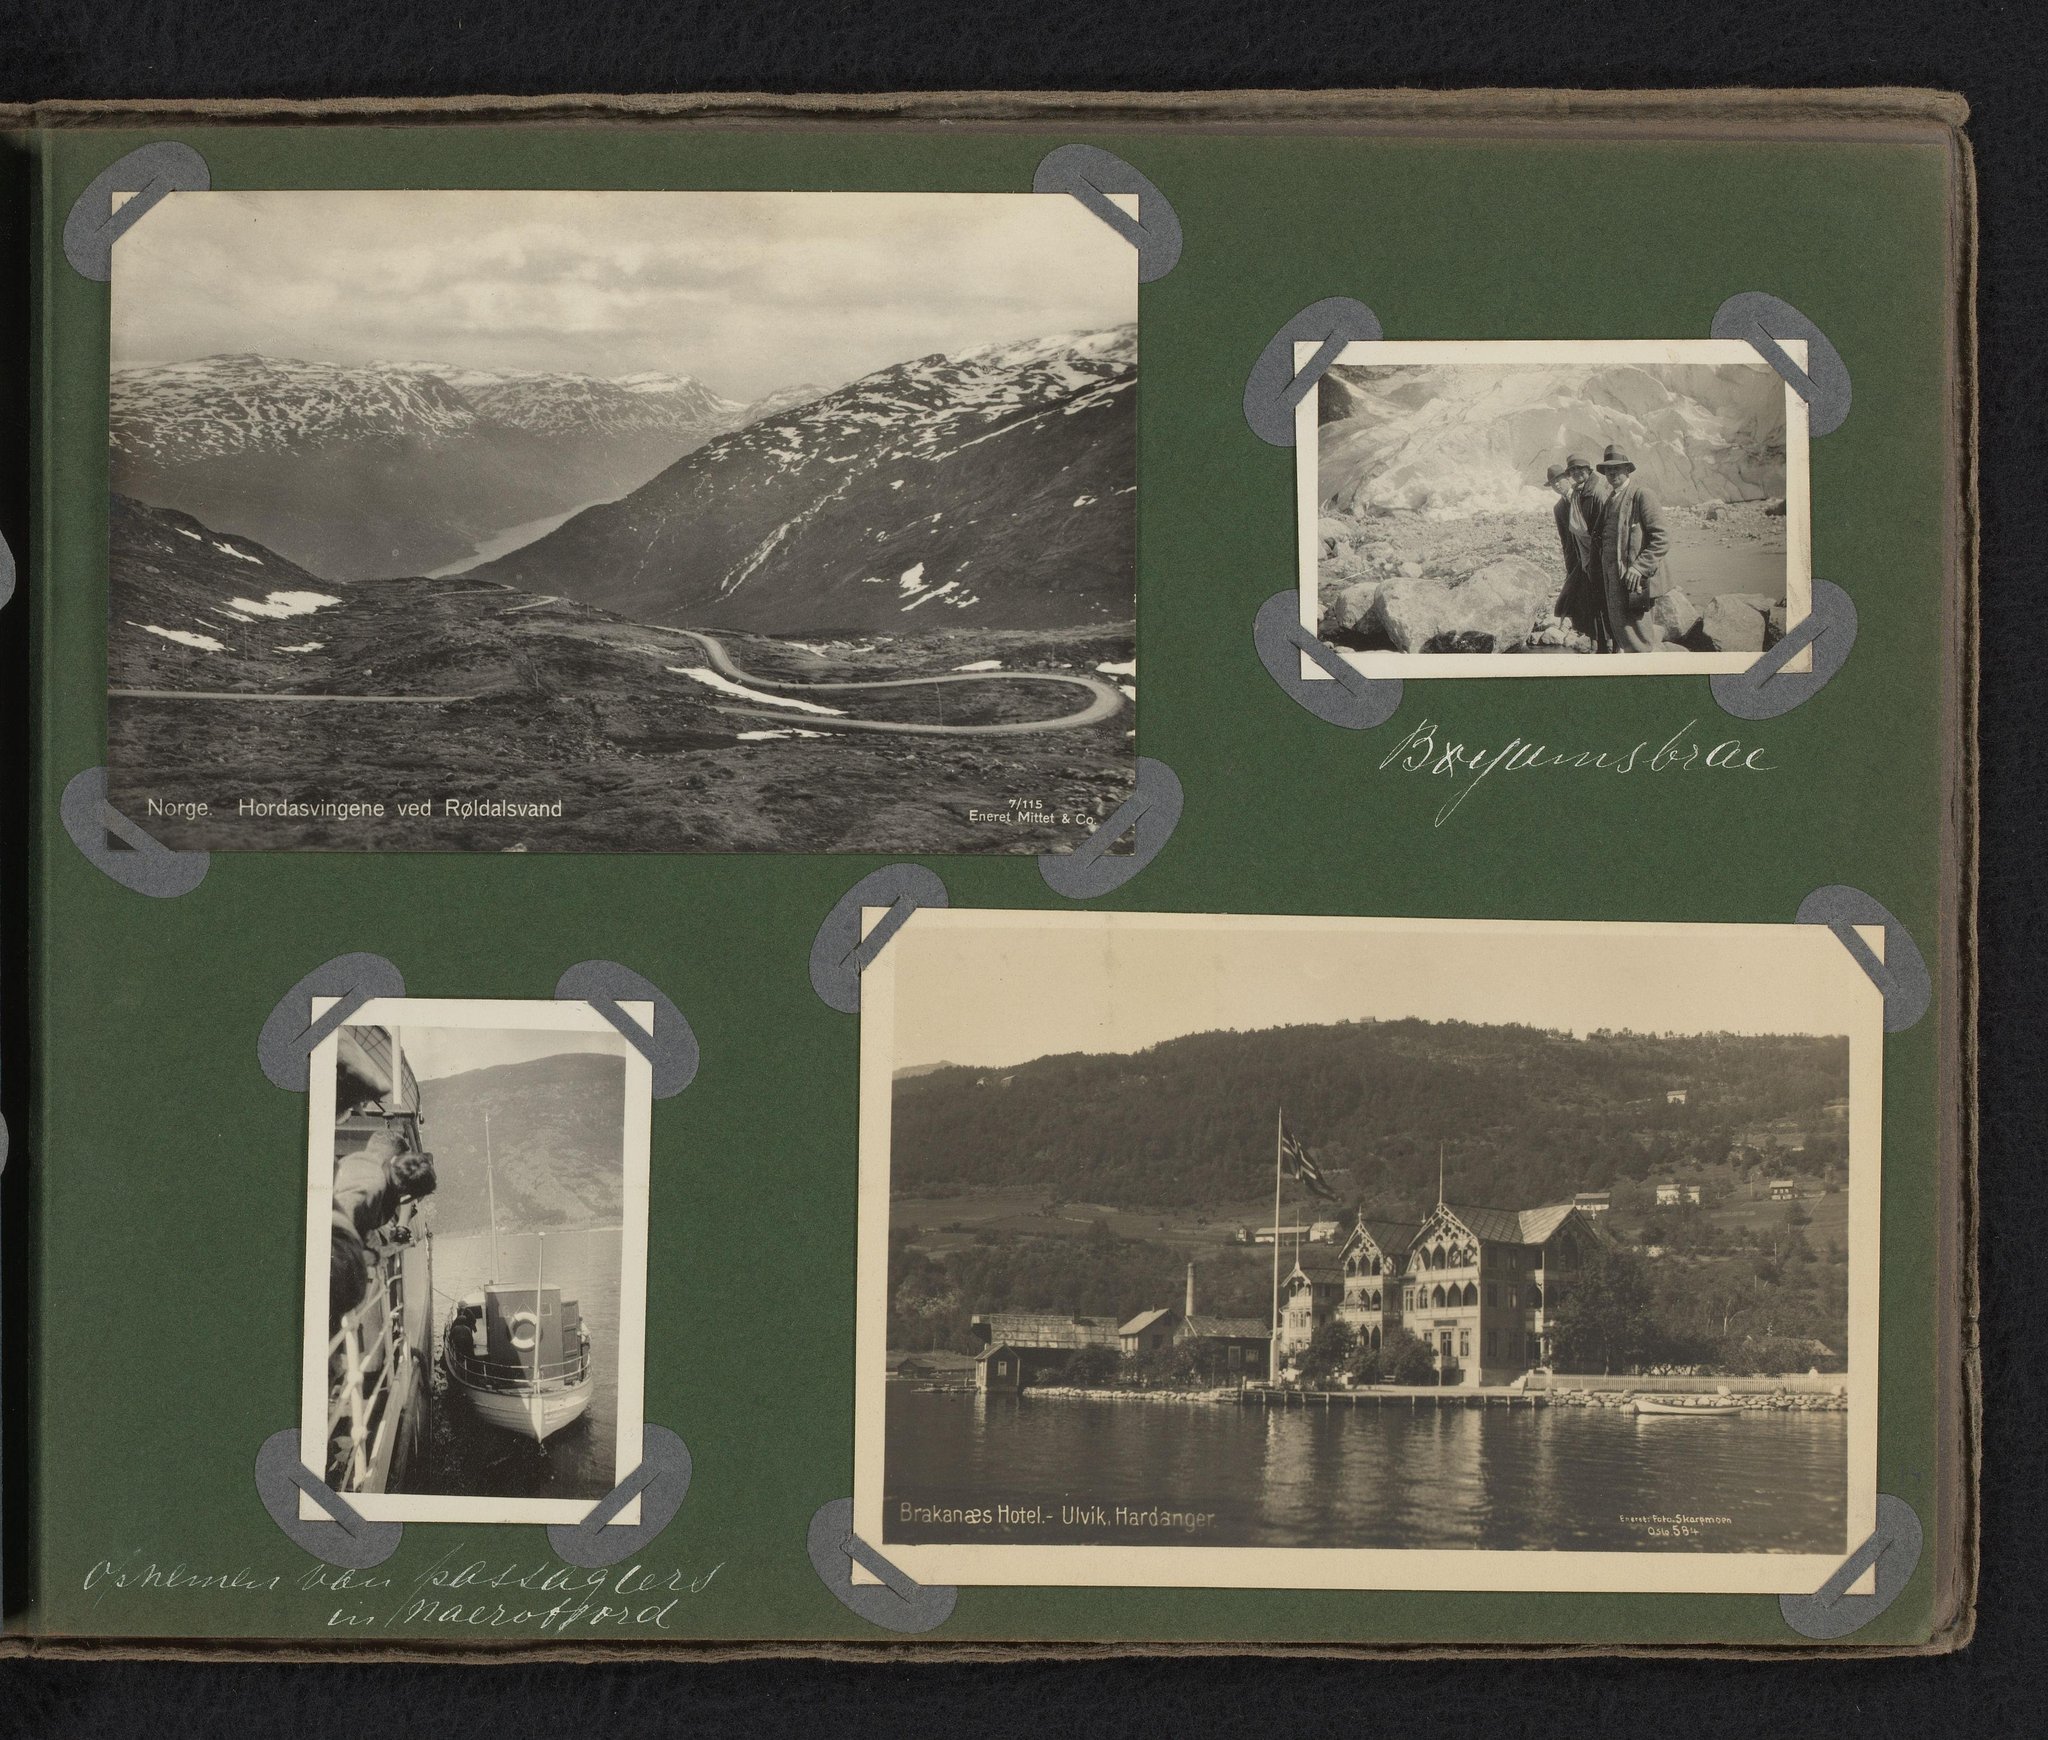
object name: photograph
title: Vier foto's van Noorwegen, waarvan twee prentbriefkaarten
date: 1927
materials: paper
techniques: gelatin silver print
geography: norway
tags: hendrik herman van den berg, the hague, caroline louise van den berg-van den berg, amsterdam, carel frederik van den berg (cay), lake, mountains, norway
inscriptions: inscription: ‘Opnemen van passagiers/ in Naerofjord’, inscription: ‘Norge. Hordasvingene ved Roldalsvand’, inscription: ‘Boyumsbrae’, inscription: ‘Barakanaes Hotel.- Ulvik. Hardanger’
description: Deze foto's maken deel uit van een album.